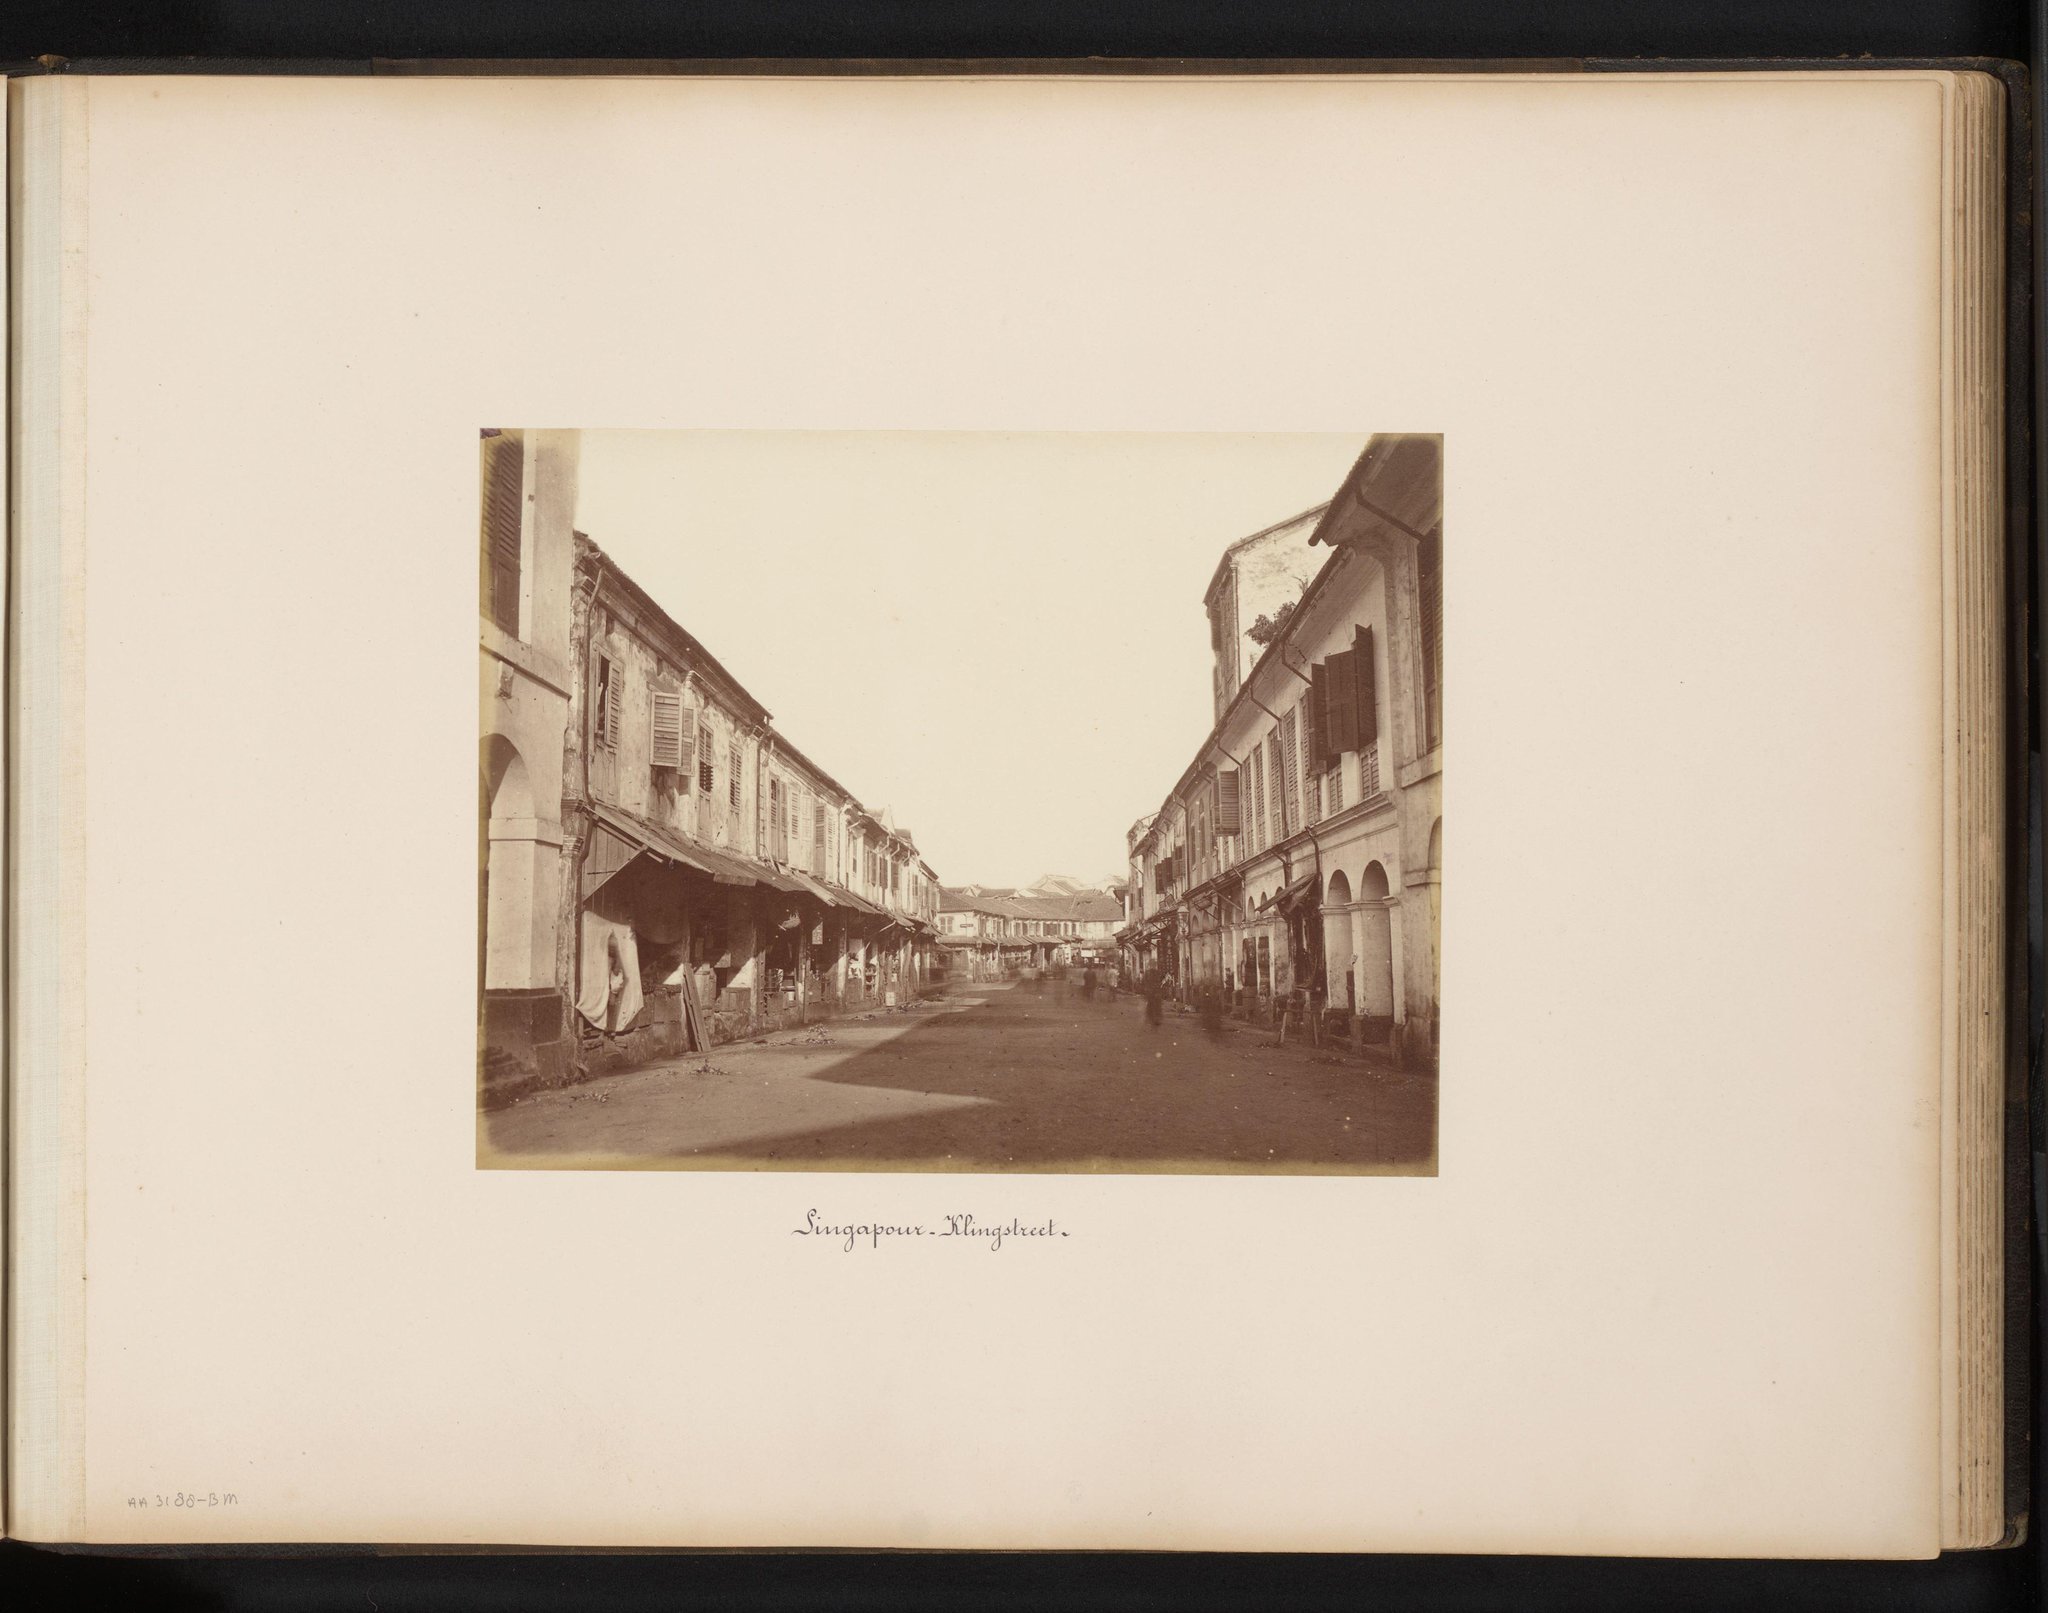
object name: photograph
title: Kling Street in Singapore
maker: Anonymous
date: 1870-1880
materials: photographic support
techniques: albumen print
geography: singapore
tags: street (+ city(-scape) with figures, staffage), singapore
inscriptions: title: ‘Singapour _ Klingstreet _’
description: Onderdeel van Reisalbum met opnames van bezienswaardigheden in Egypte, Nederlands-Indië, Singapore en Ceylon.